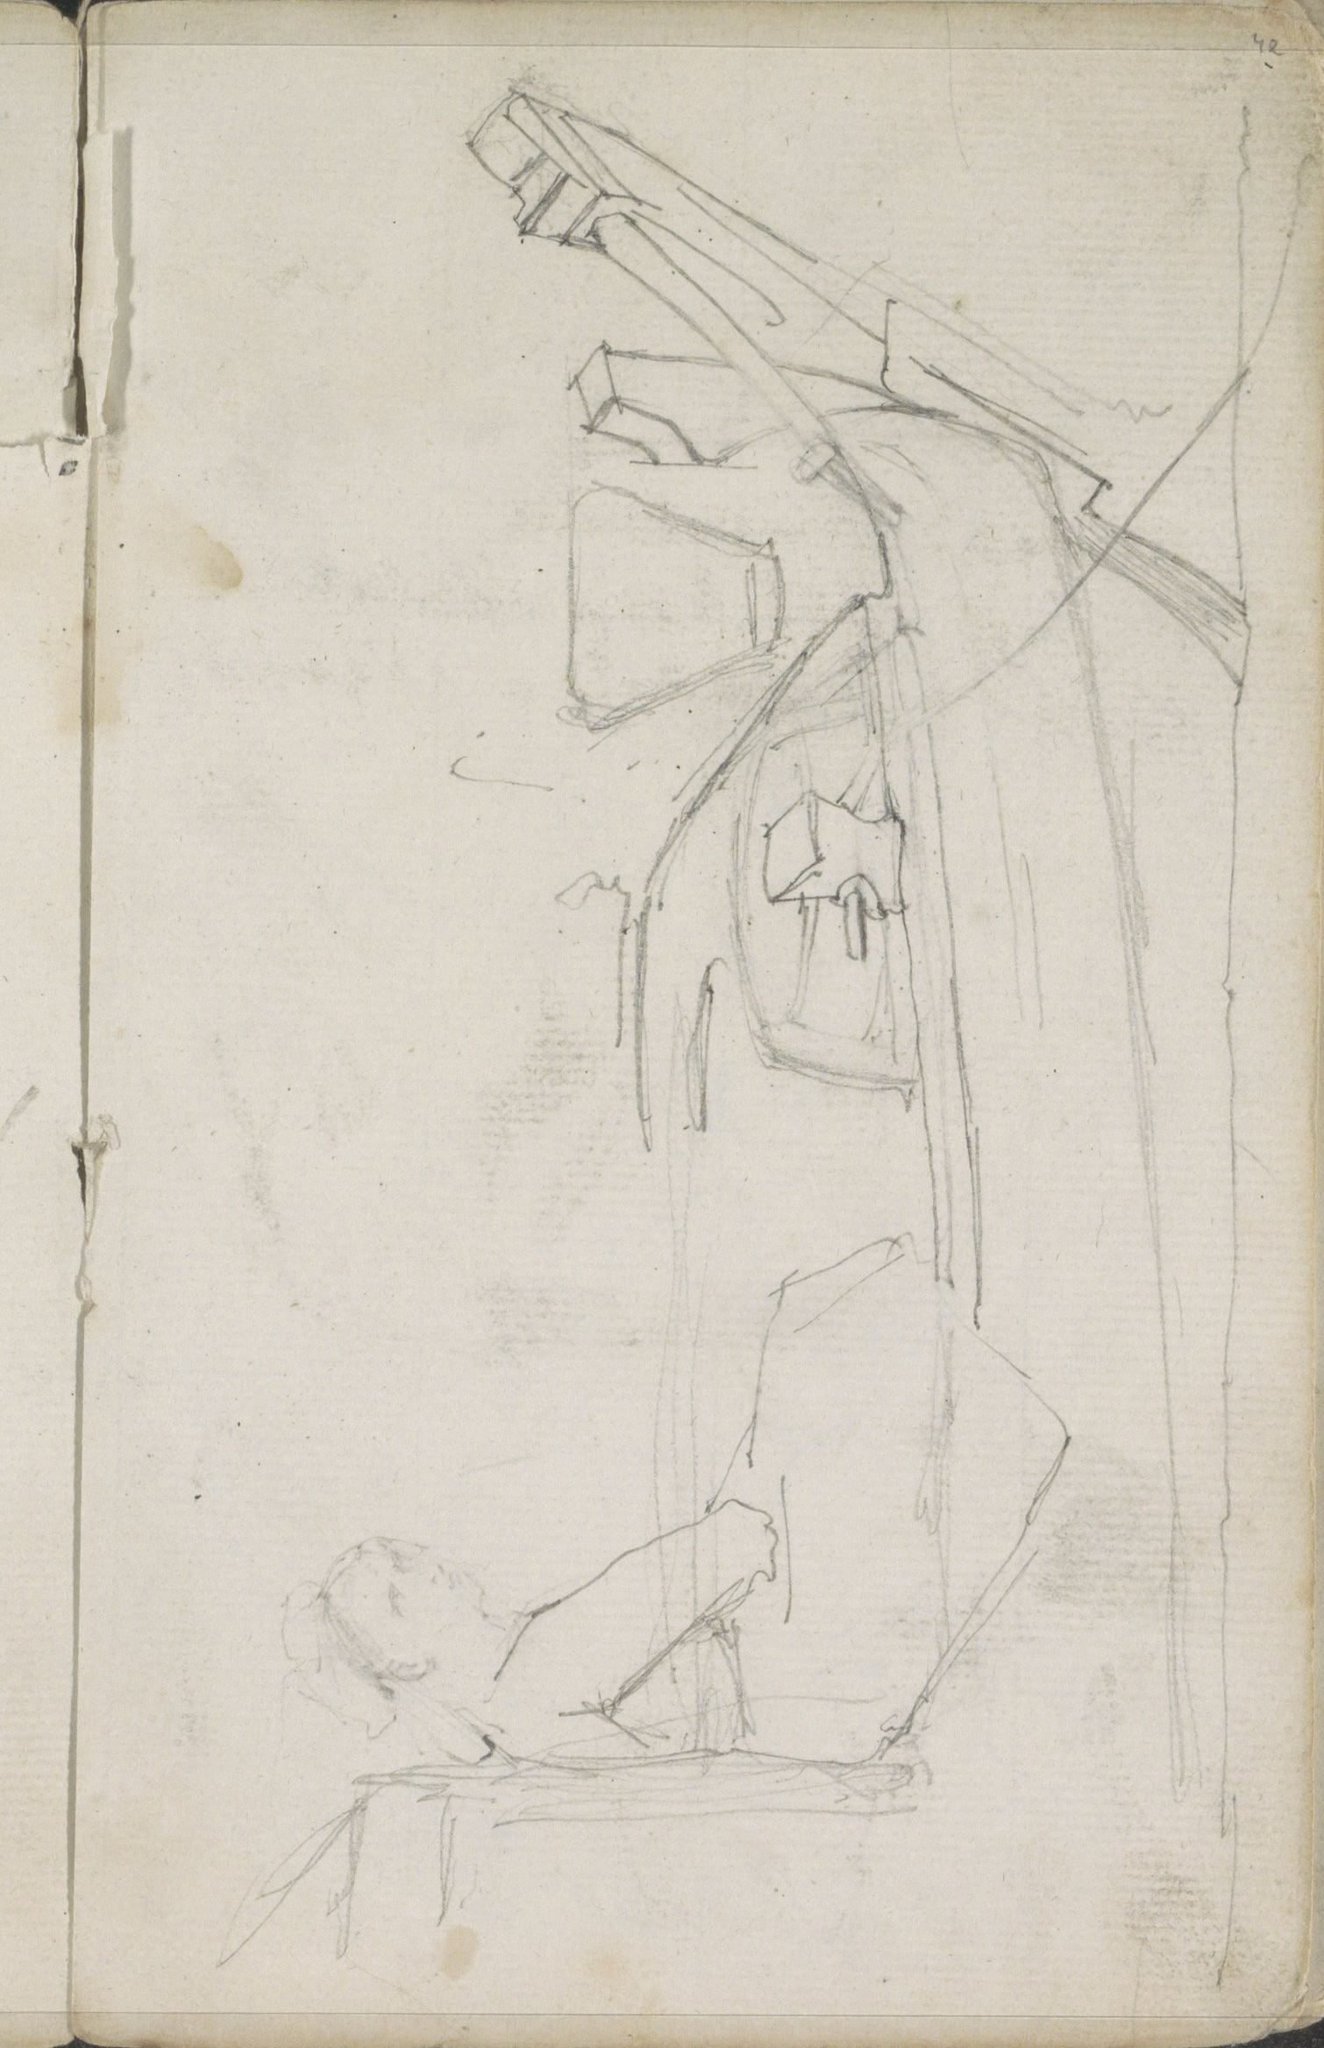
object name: sketchbook leaf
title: Vrouw in een roeiboot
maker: george hendrik breitner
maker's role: draughtsman, painter, print maker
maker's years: 1857-1923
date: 1880-1882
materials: paper, pencil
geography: the hague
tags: sitting figure - aa - female human figure, rowing-boat, canoe, etc.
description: Pagina 42 uit een schetsboek met 29 bladen.